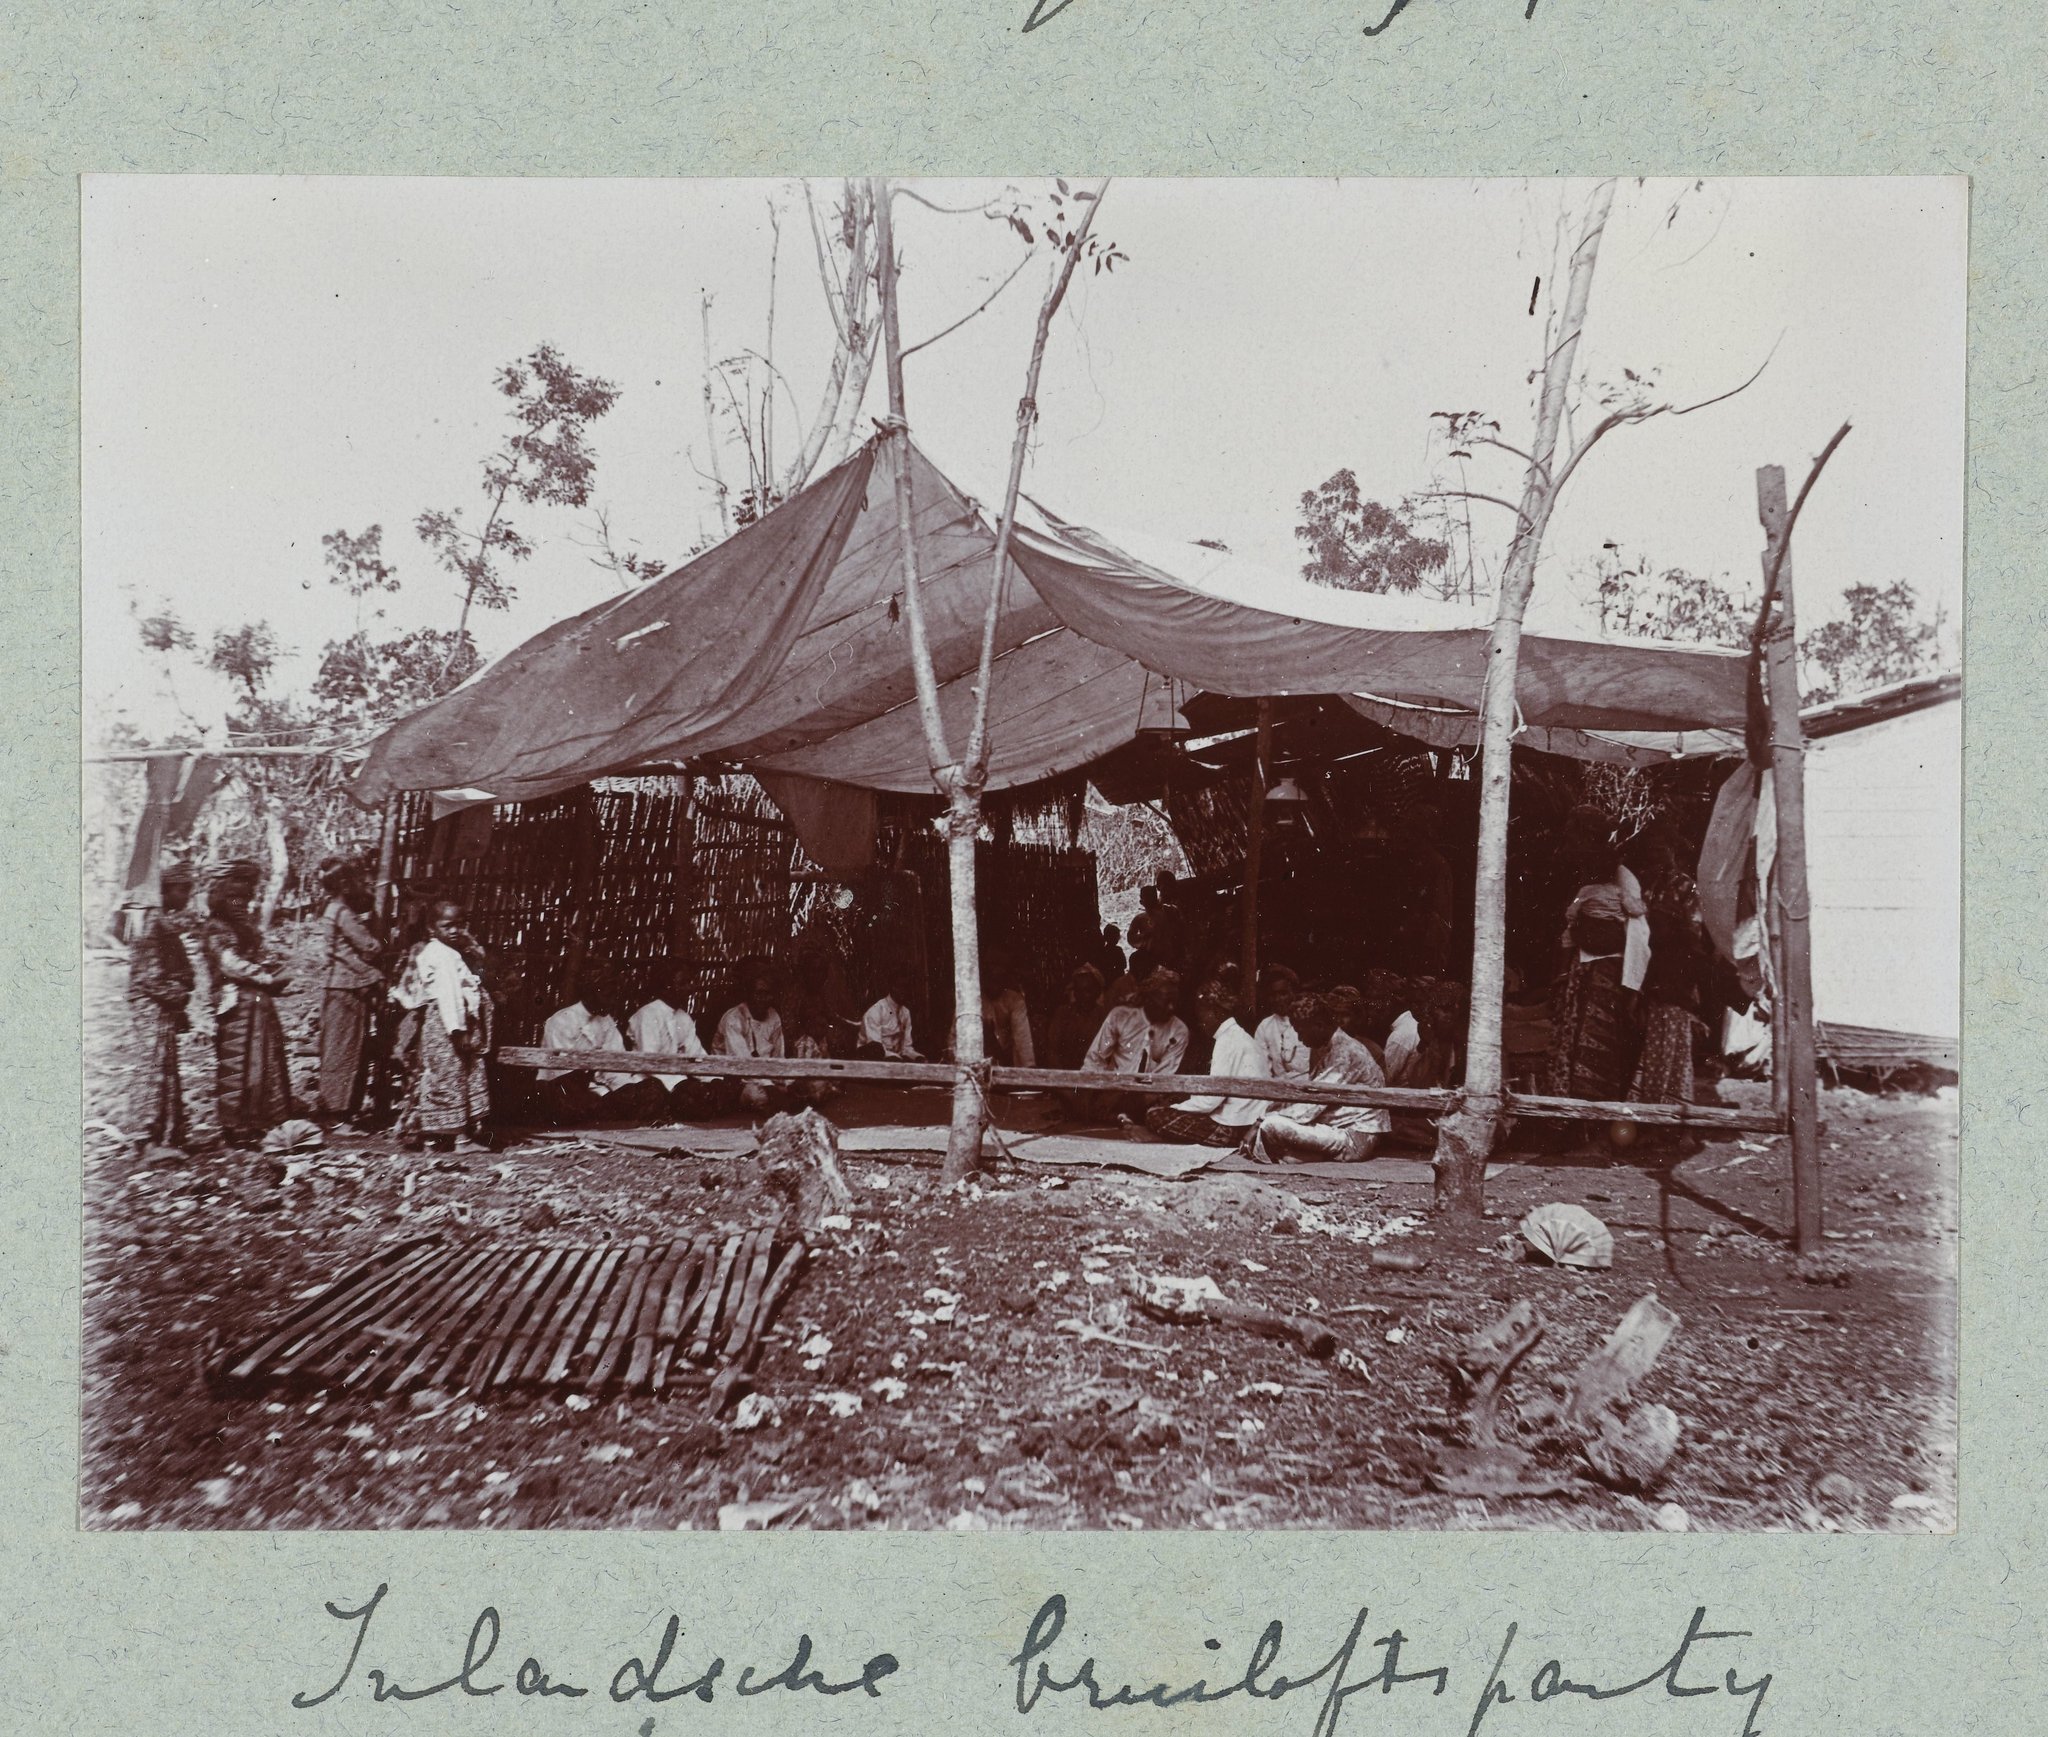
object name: photograph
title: Bruiloft in de buurt van Kalianget, Madura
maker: frits freerks fontein fz.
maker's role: fotograaf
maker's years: 1882-1928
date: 1912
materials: cardboard, paper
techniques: gelatin silver print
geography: netherlands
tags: wedding feast, wedding meal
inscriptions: caption: ‘Inlandsche bruiloftsparty nabij Kalianget. 1914’